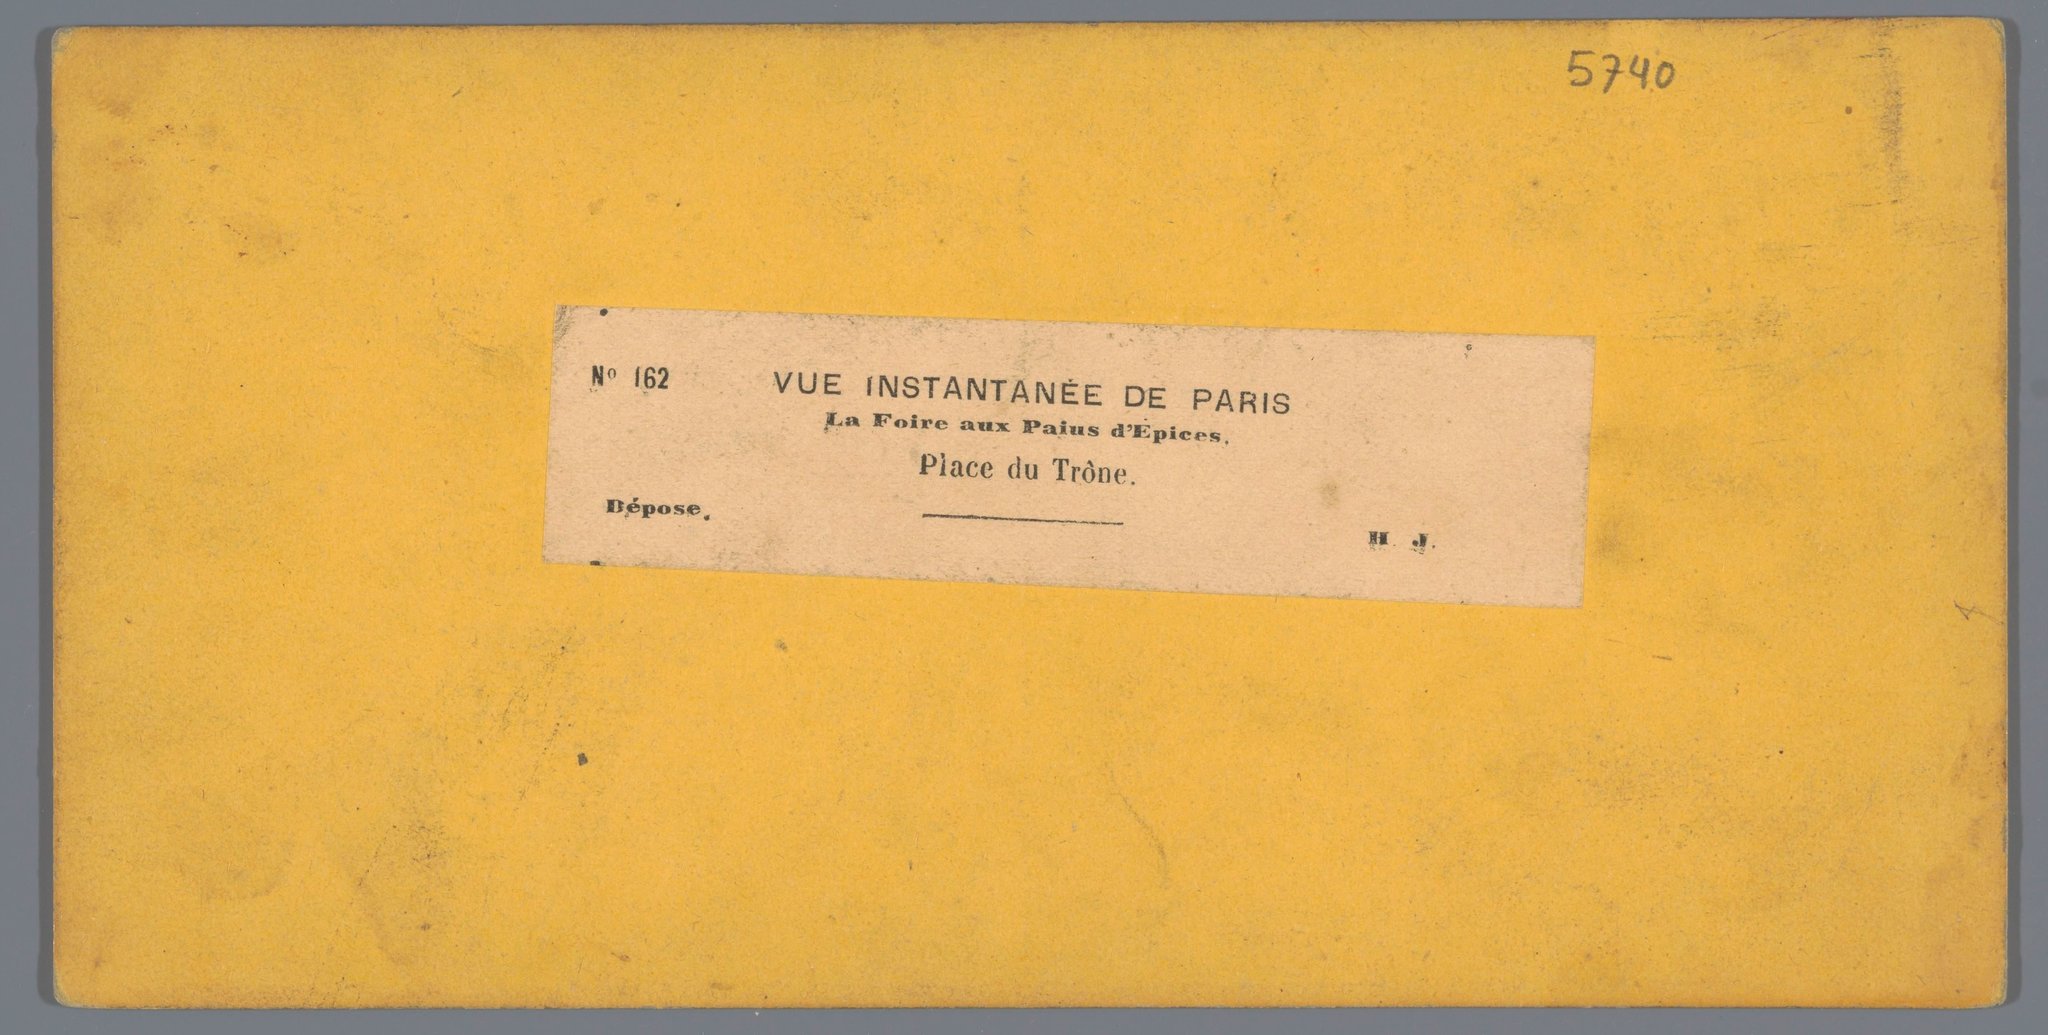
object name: stereograph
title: Gezicht op het feest Foire aux pains d’épices op het place du Trône in Parijs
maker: hippolyte jouvin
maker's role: fotograaf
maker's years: 1825-1889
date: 1850-1880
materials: cardboard, photographic support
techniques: albumen print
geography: paris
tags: pleasure fair and circus, paris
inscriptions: number: ‘No 162’